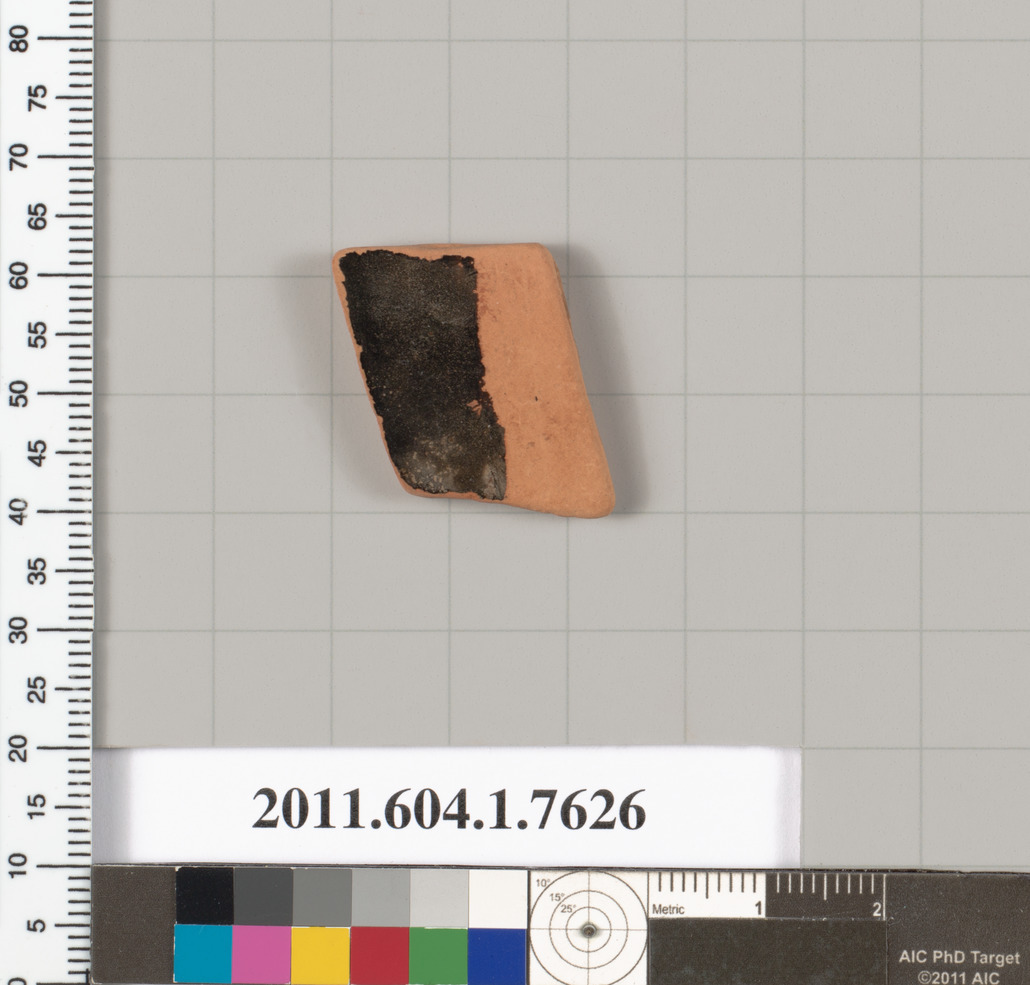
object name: kylix fragment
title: Terracotta fragment of a kylix (drinking cup)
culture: greek, attic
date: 460-450 BCE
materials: terracotta